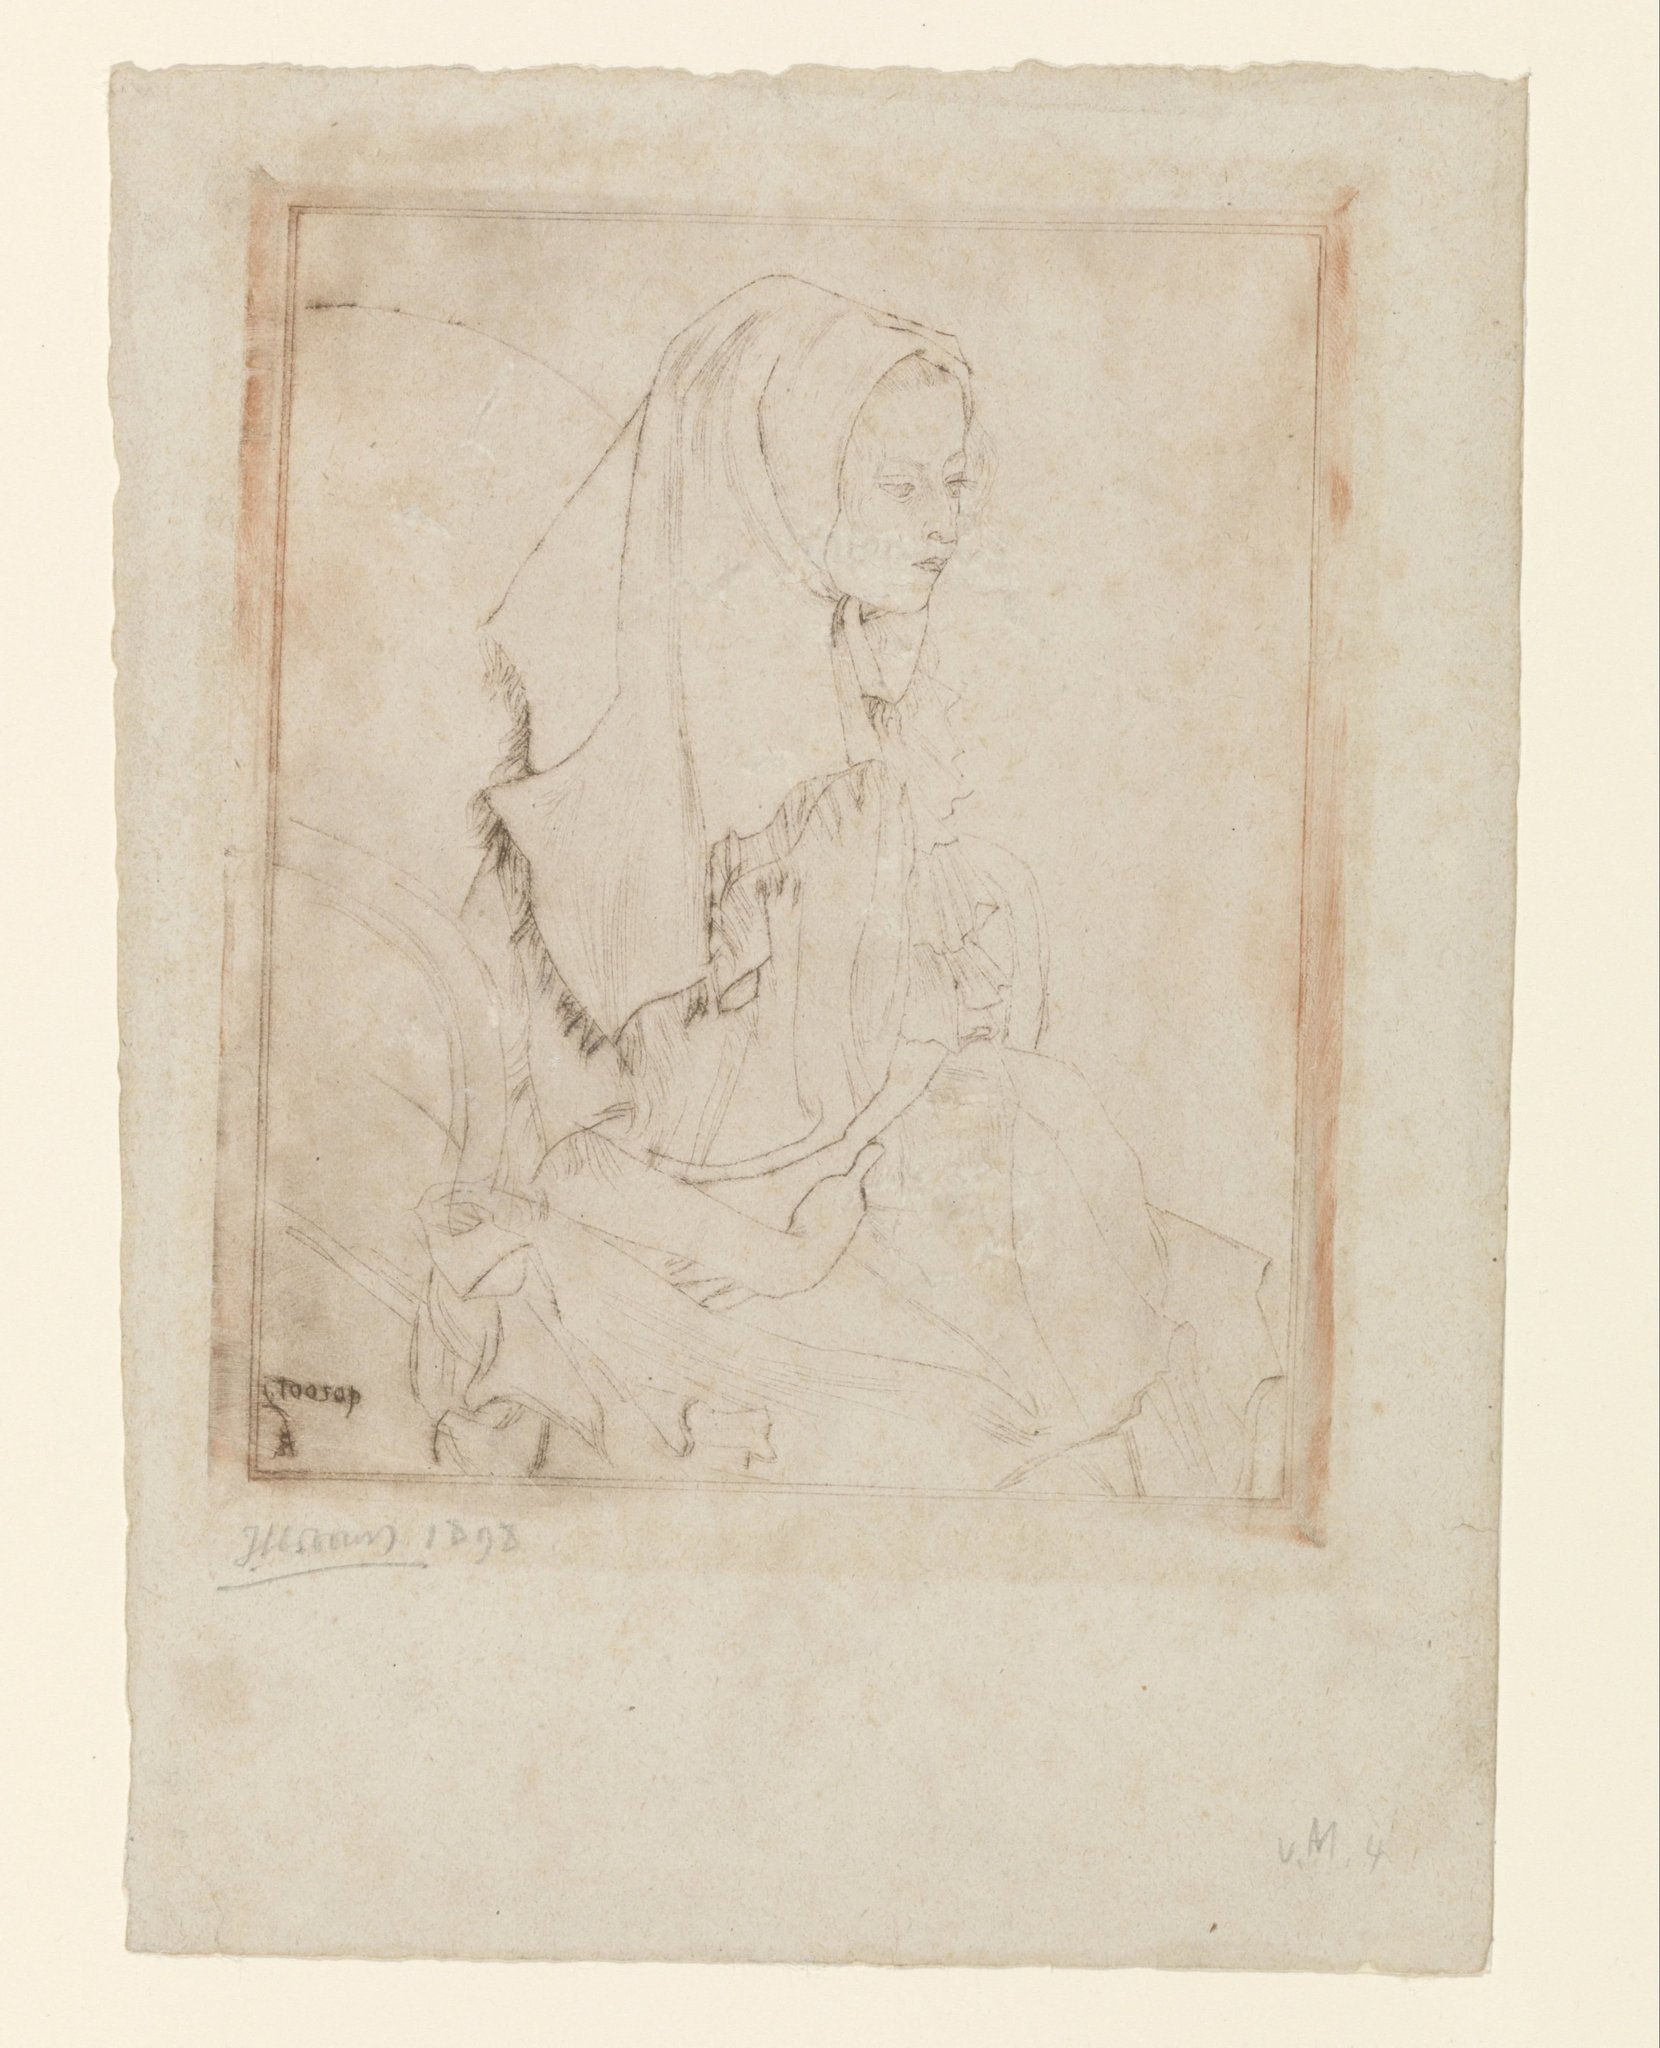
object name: print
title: Ziek kind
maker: jan toorop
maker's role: draughtsman, painter, print maker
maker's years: 1858-1928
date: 1898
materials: paper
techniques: drypoint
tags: print maker, draughtsman, charley toorop, historical persons, girl (child between toddler and youth), patient, sick person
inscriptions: collector's mark: Lugt 2228, collector's mark: Lugt 2760